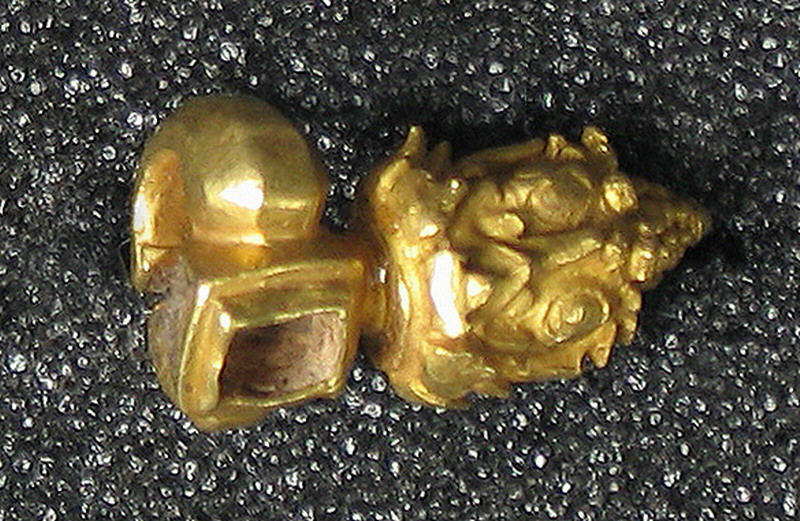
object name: earring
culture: indonesian, central java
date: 701-1200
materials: gold